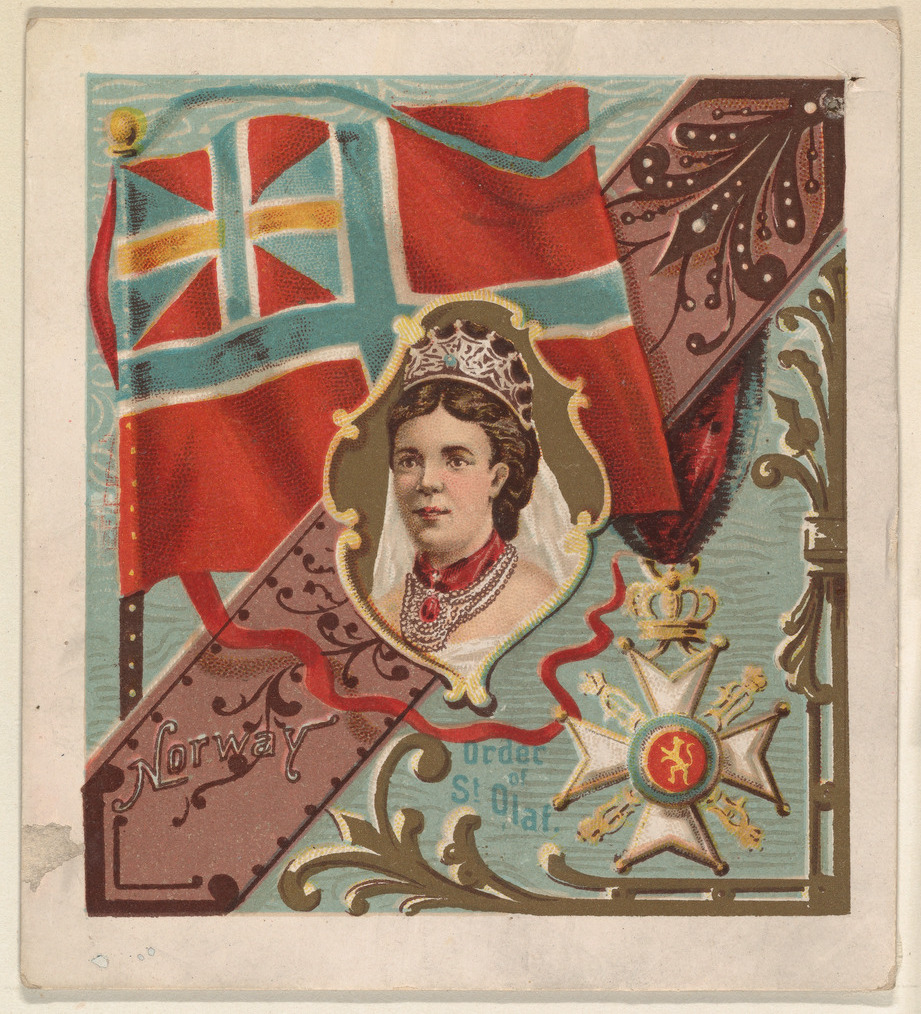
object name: print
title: Norway, from the International Cards series (N238), issued by Kinney Bros.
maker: kinney brothers tobacco company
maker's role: publisher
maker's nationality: american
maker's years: 1869-2011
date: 1888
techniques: color lithograph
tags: women,flags